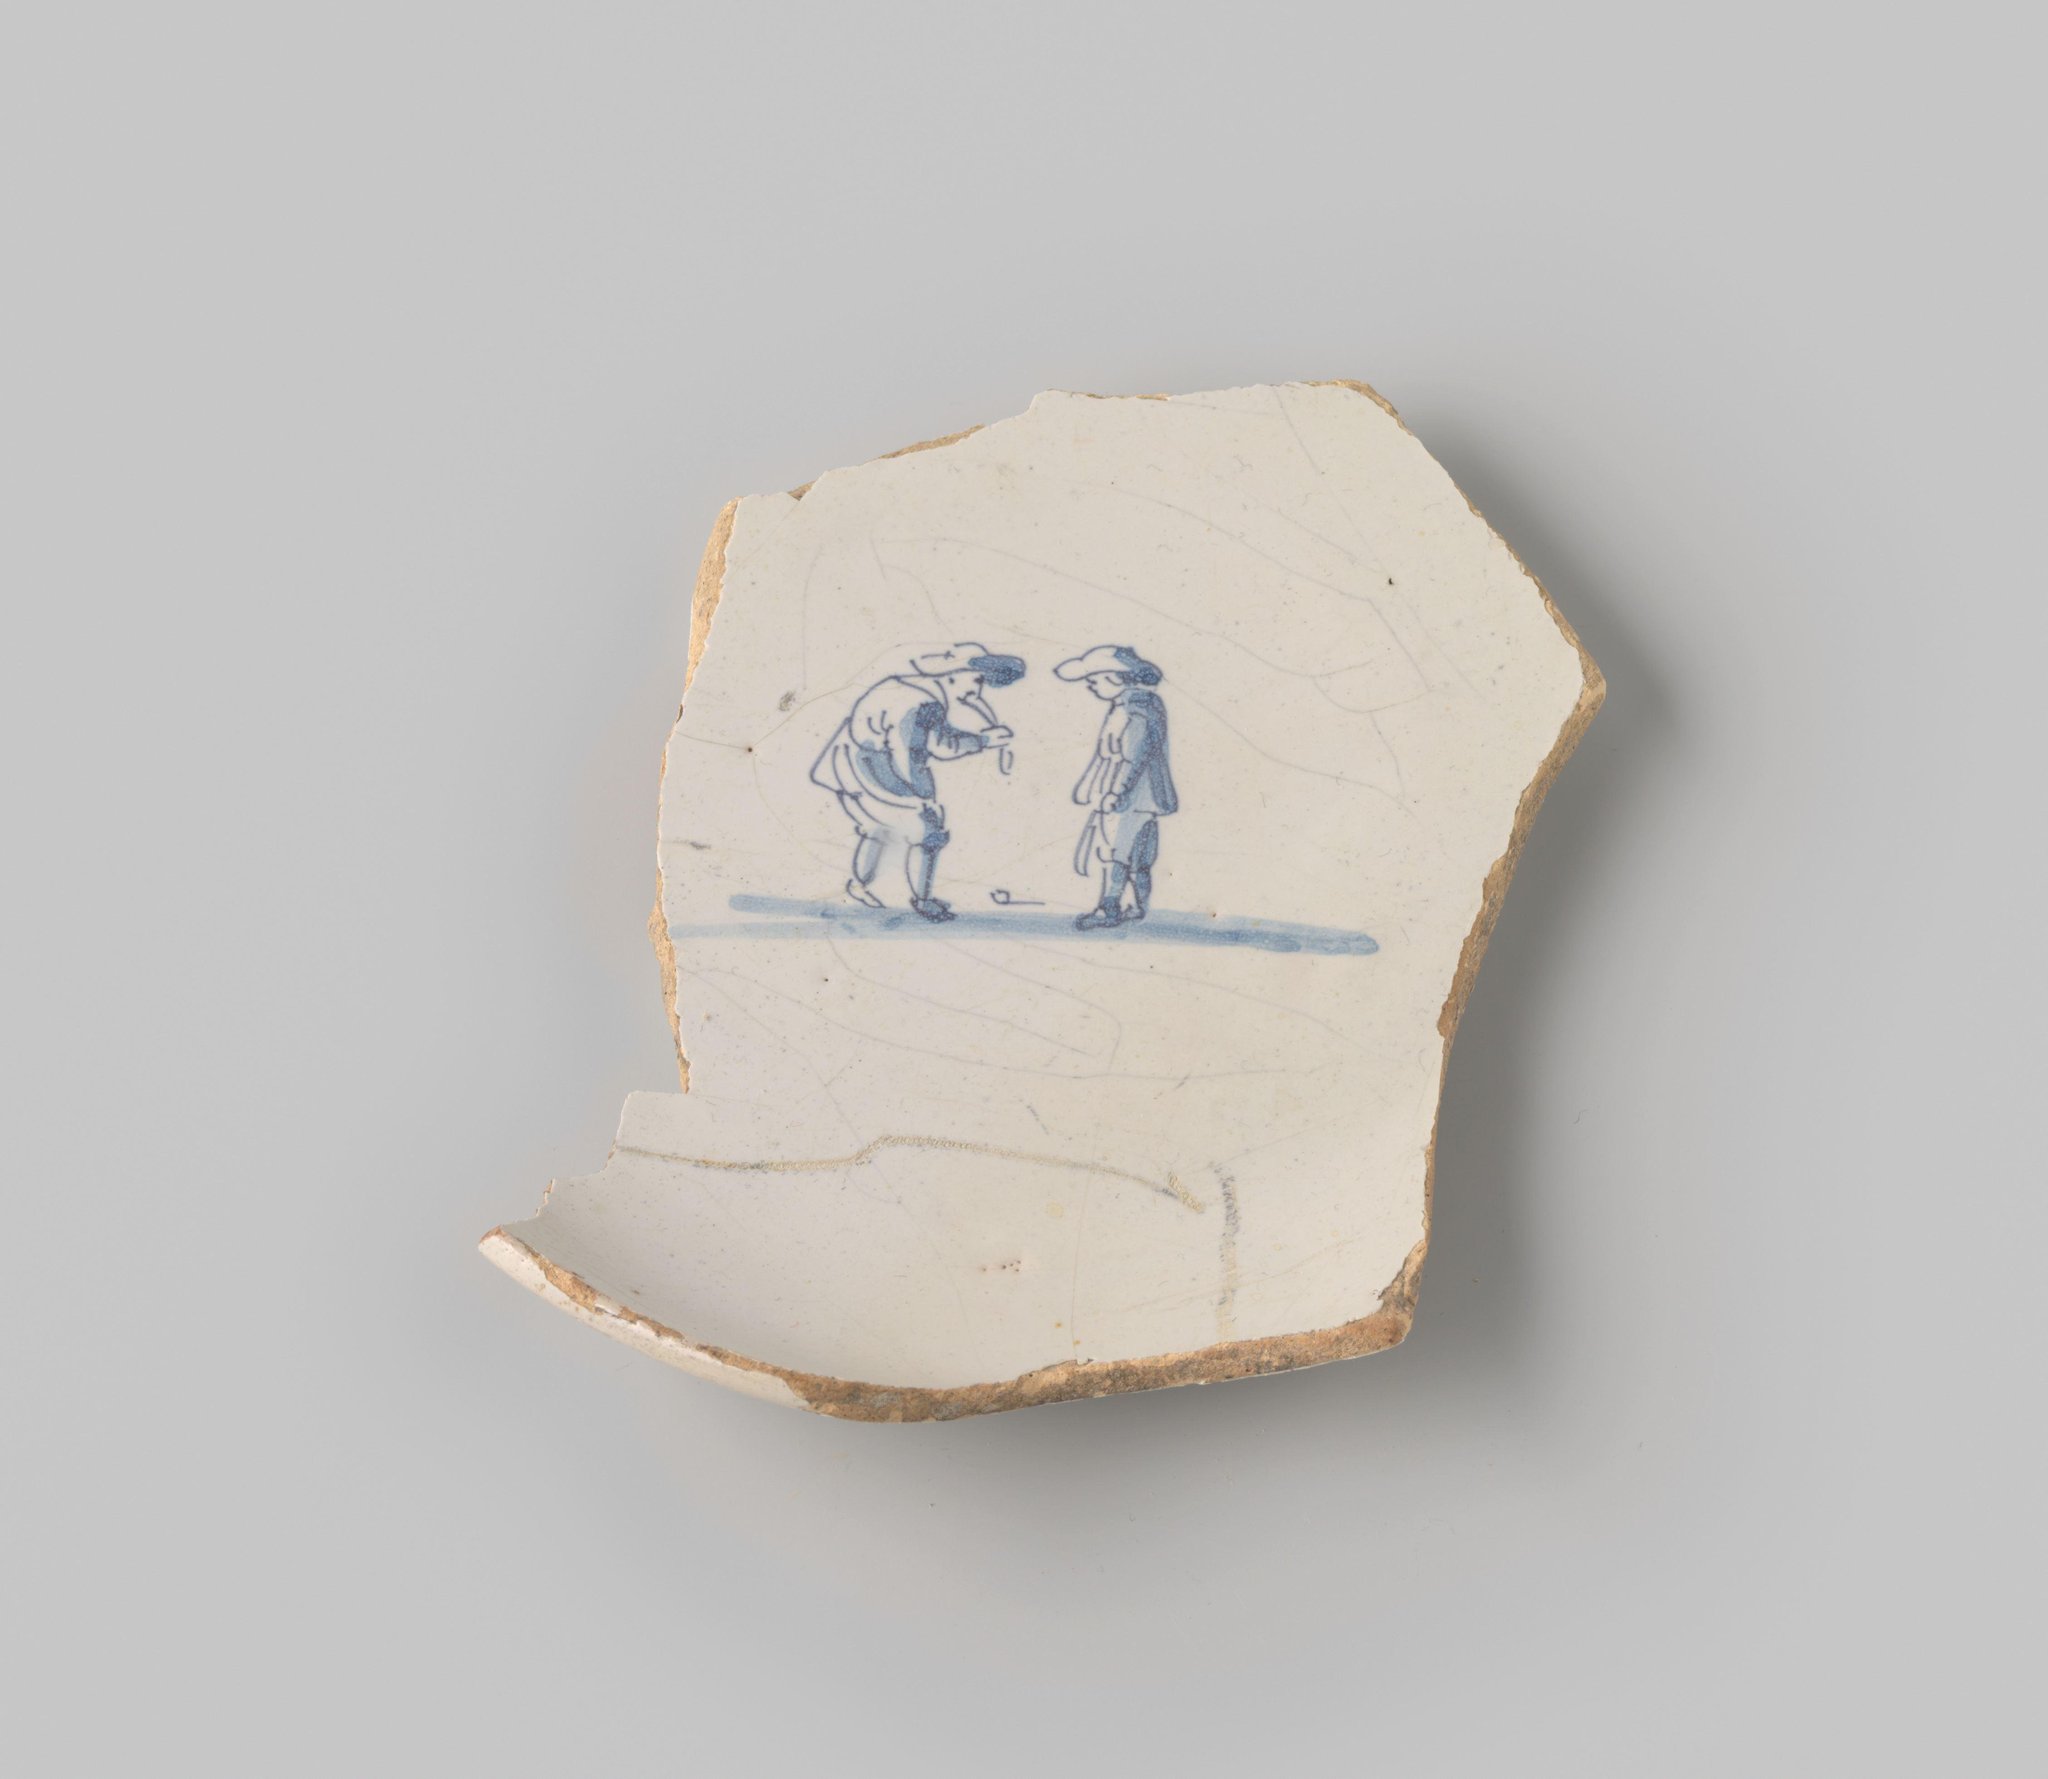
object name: sherd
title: Scherf van witbakkend aardewerk, met standring, aan de voor- en achterzijde voorzien van wit glazuur, aan de voorzijde met een schildering van twee figuren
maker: Anonymous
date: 1600-1650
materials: earthenware, glaze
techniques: maiolica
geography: northern netherlands